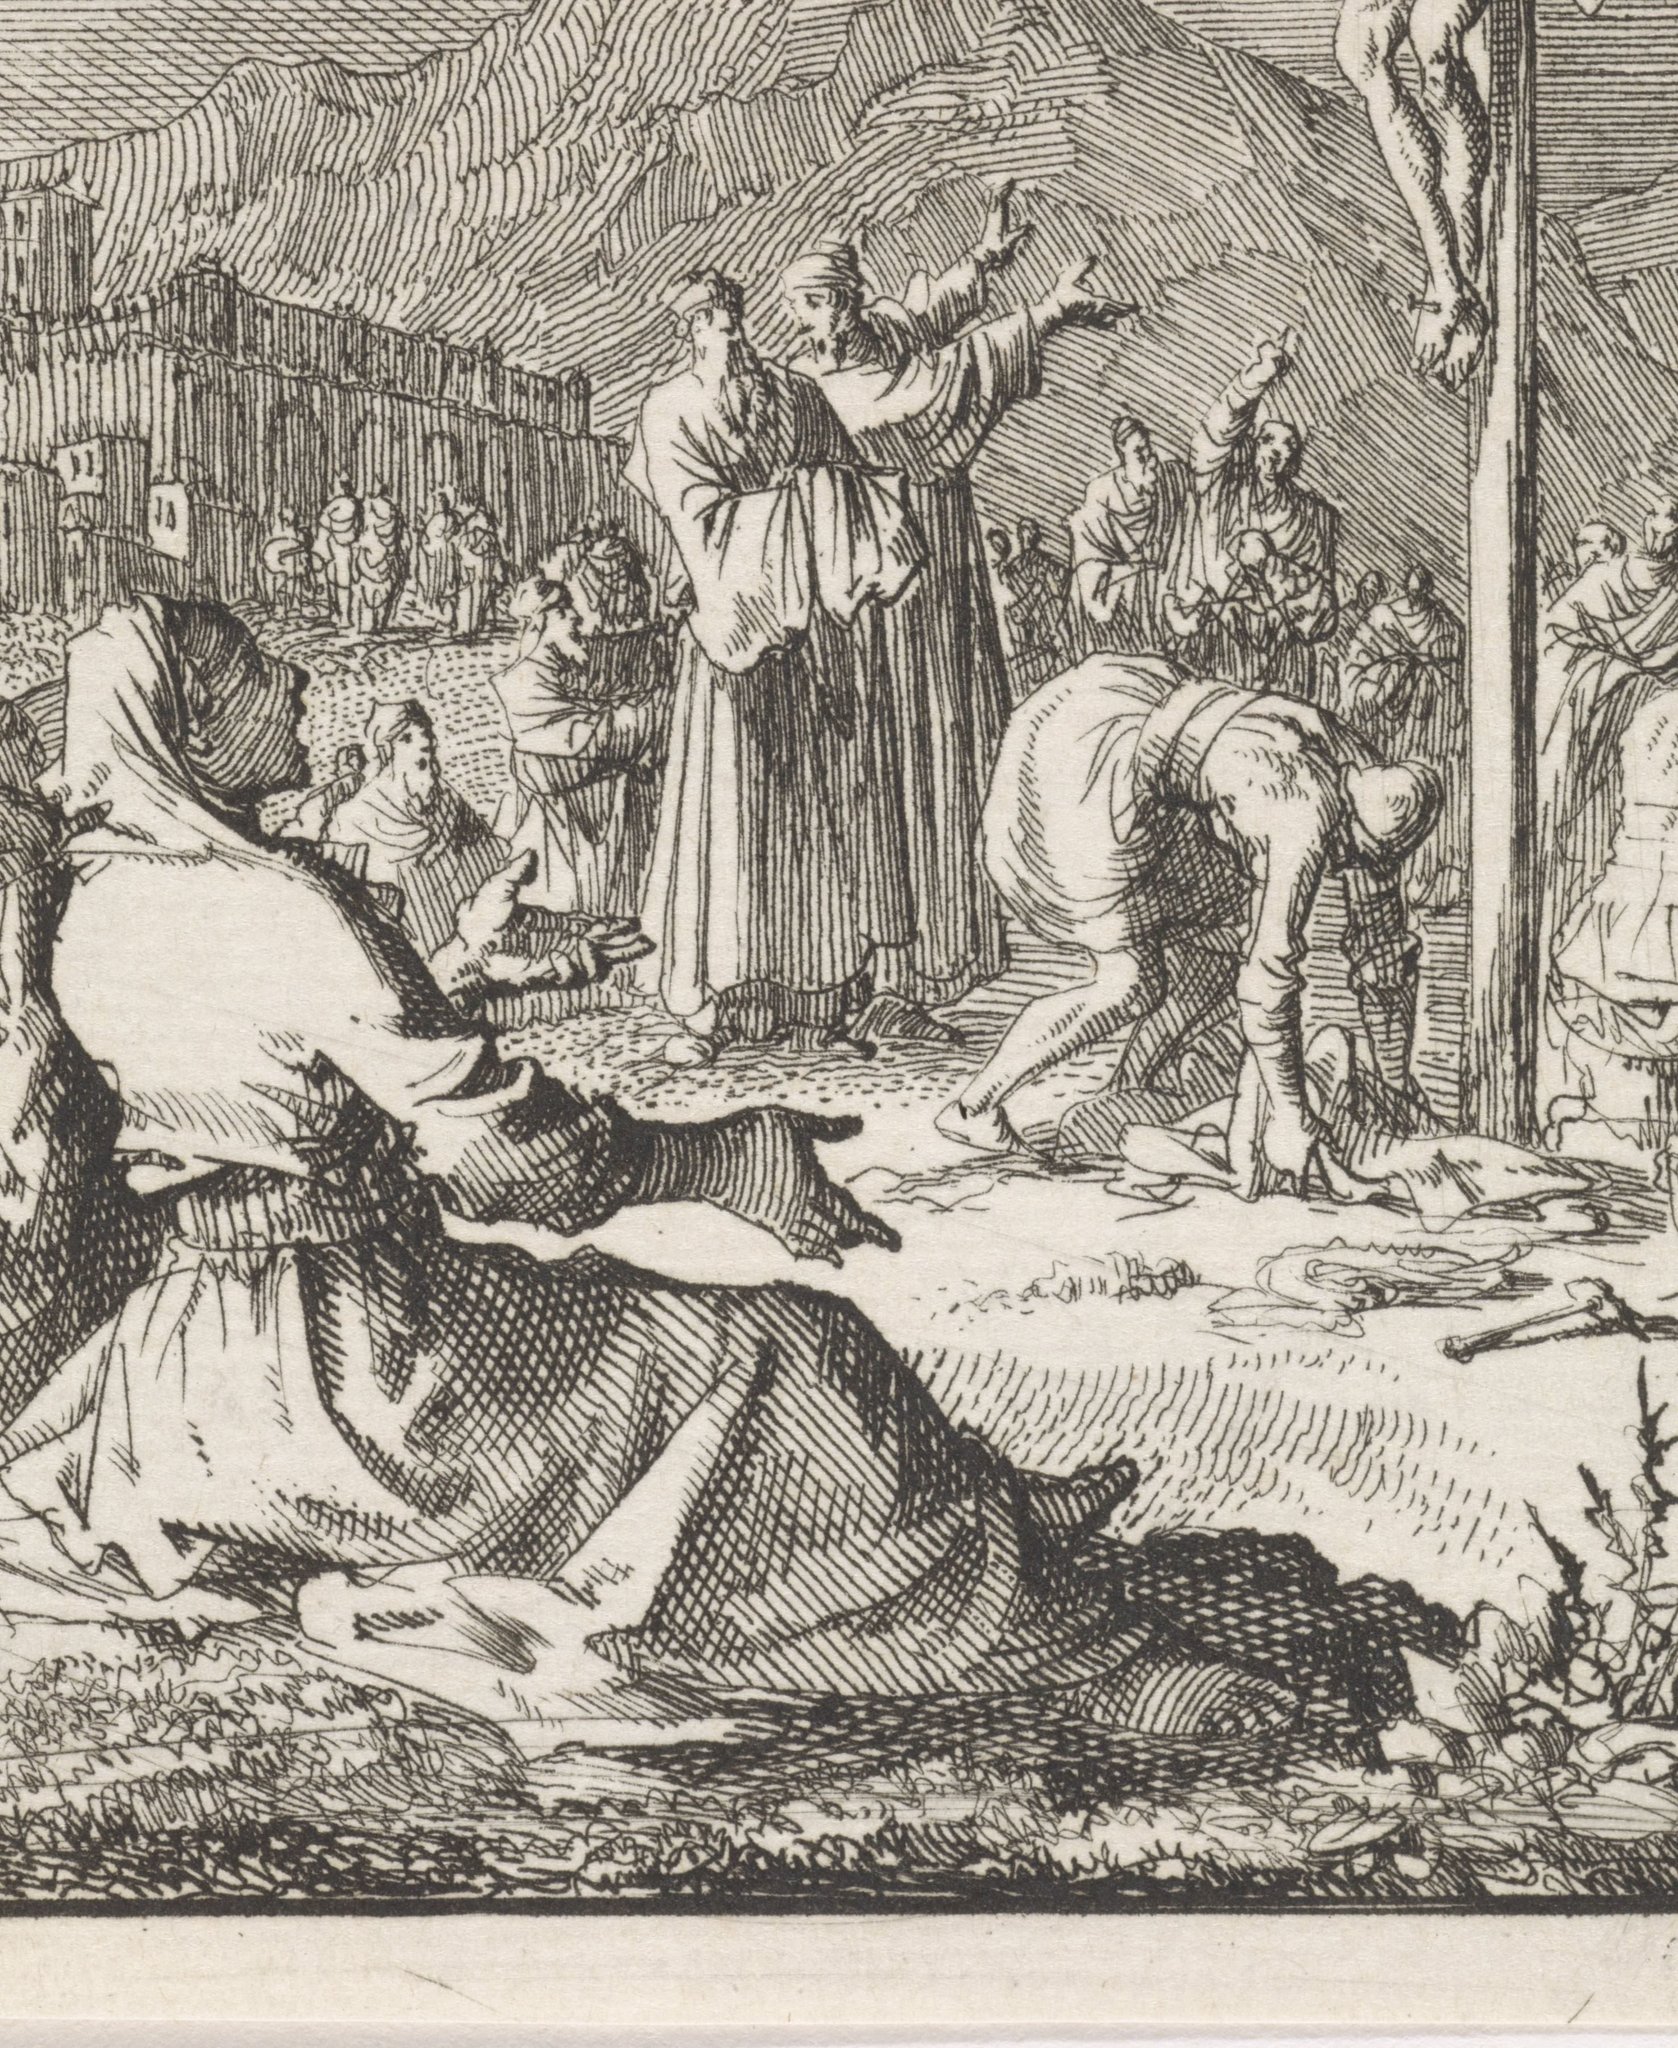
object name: book illustration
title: Christus aan het kruis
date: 1700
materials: paper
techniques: etching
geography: amsterdam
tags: comprehensive representations of the events on golgotha during christ's hanging on the cross, no particular event emphasized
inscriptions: collector's mark: Lugt 2228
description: Boekillustratie voor Jan Huygen. Stichtelyke rymen op verscheiden stoffen. Amsterdam: Gedrukt door Jacobus van Herdenberg voor Jan Huygen, 1700, p. 18.